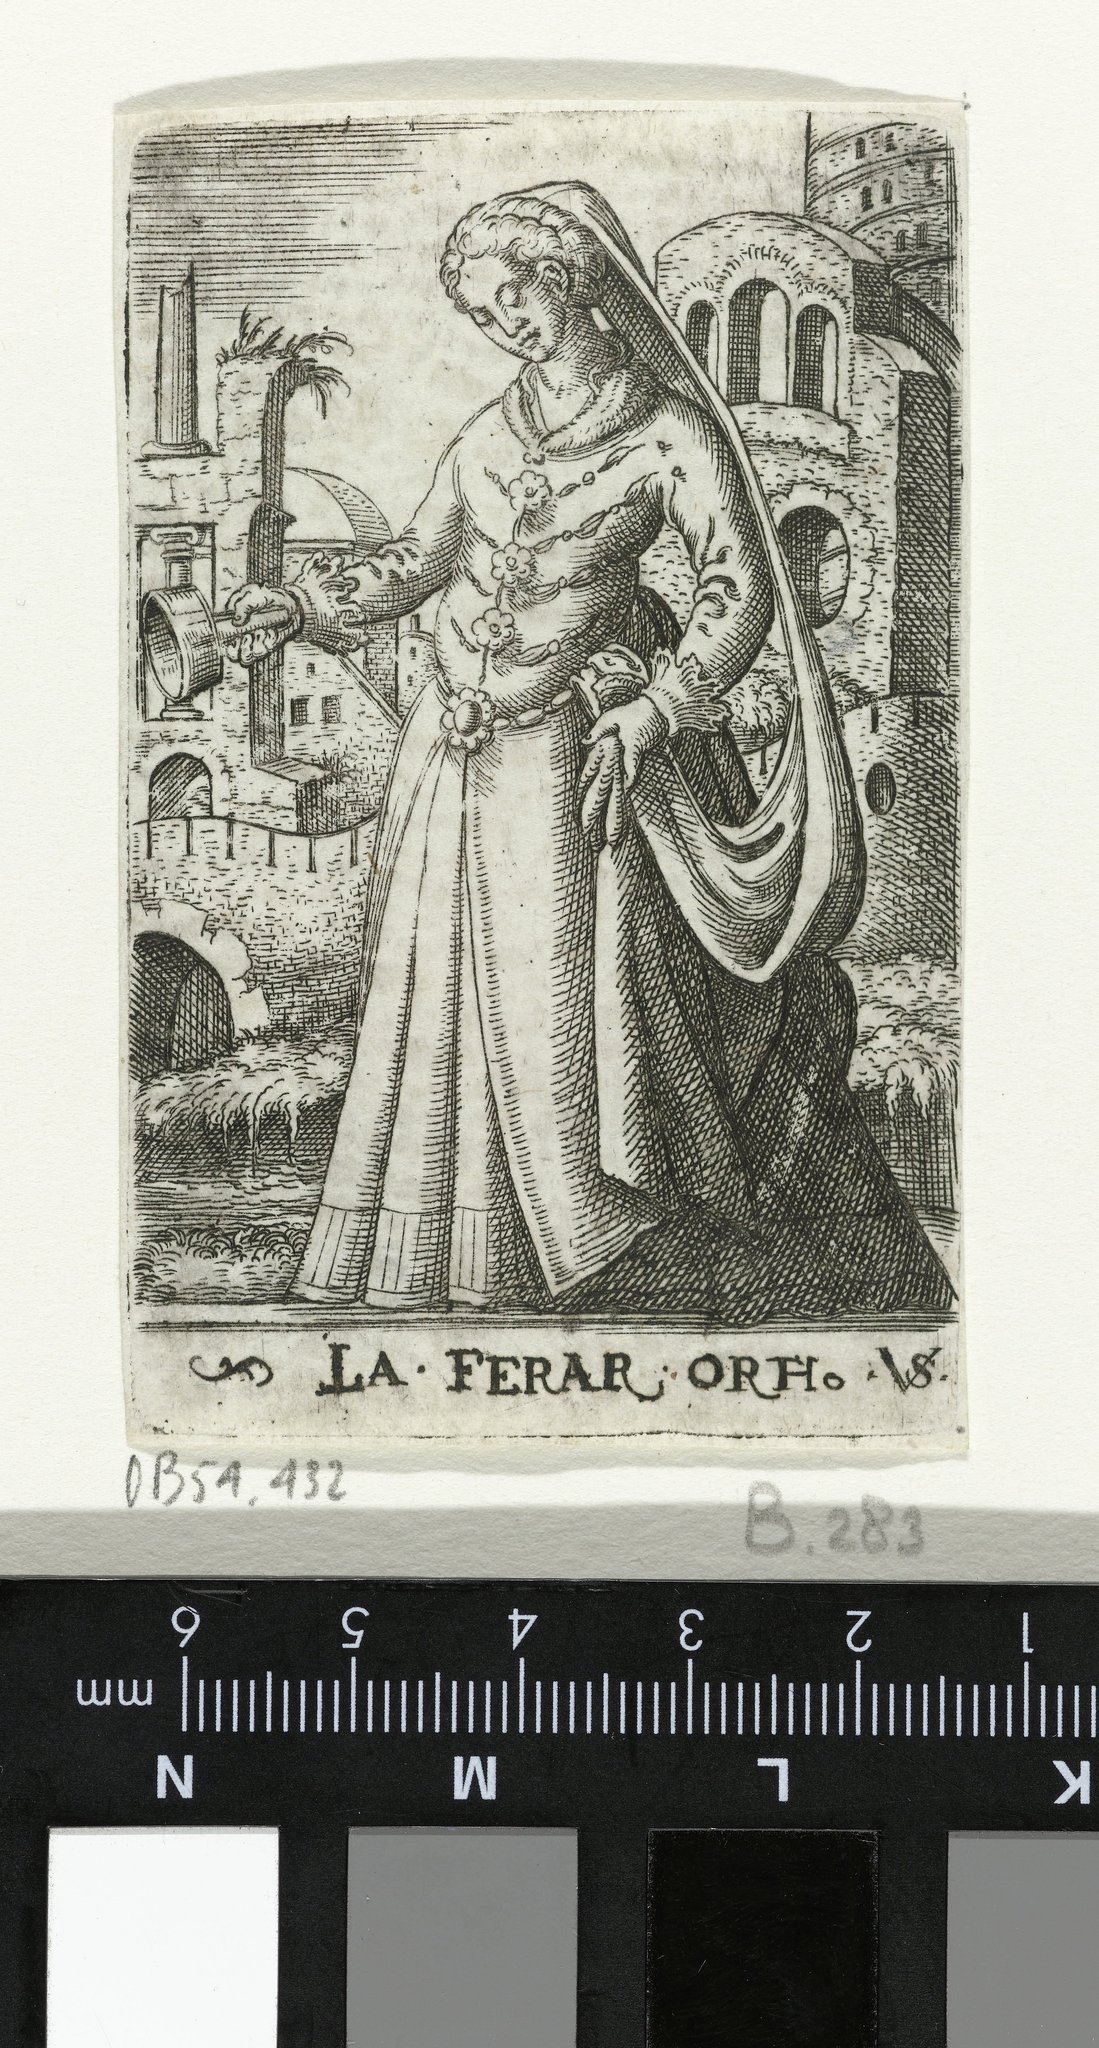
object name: print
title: Wijze en dwaze maagden als Europese landen en provinciën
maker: virgilius solis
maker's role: draughtsman, print maker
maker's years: 1514-1562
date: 1524-1562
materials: paper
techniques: engraving, etching, intaglio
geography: nuremberg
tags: personifications of countries, nations, states, districts, etc., representation of foolish virgin(s)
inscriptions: collector's mark: Lugt 2228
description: Prent maakt deel uit van een serie van tien prenten met personificaties van Europese landen en provinciën als de vijf wijze en vijf dwaze maagden.